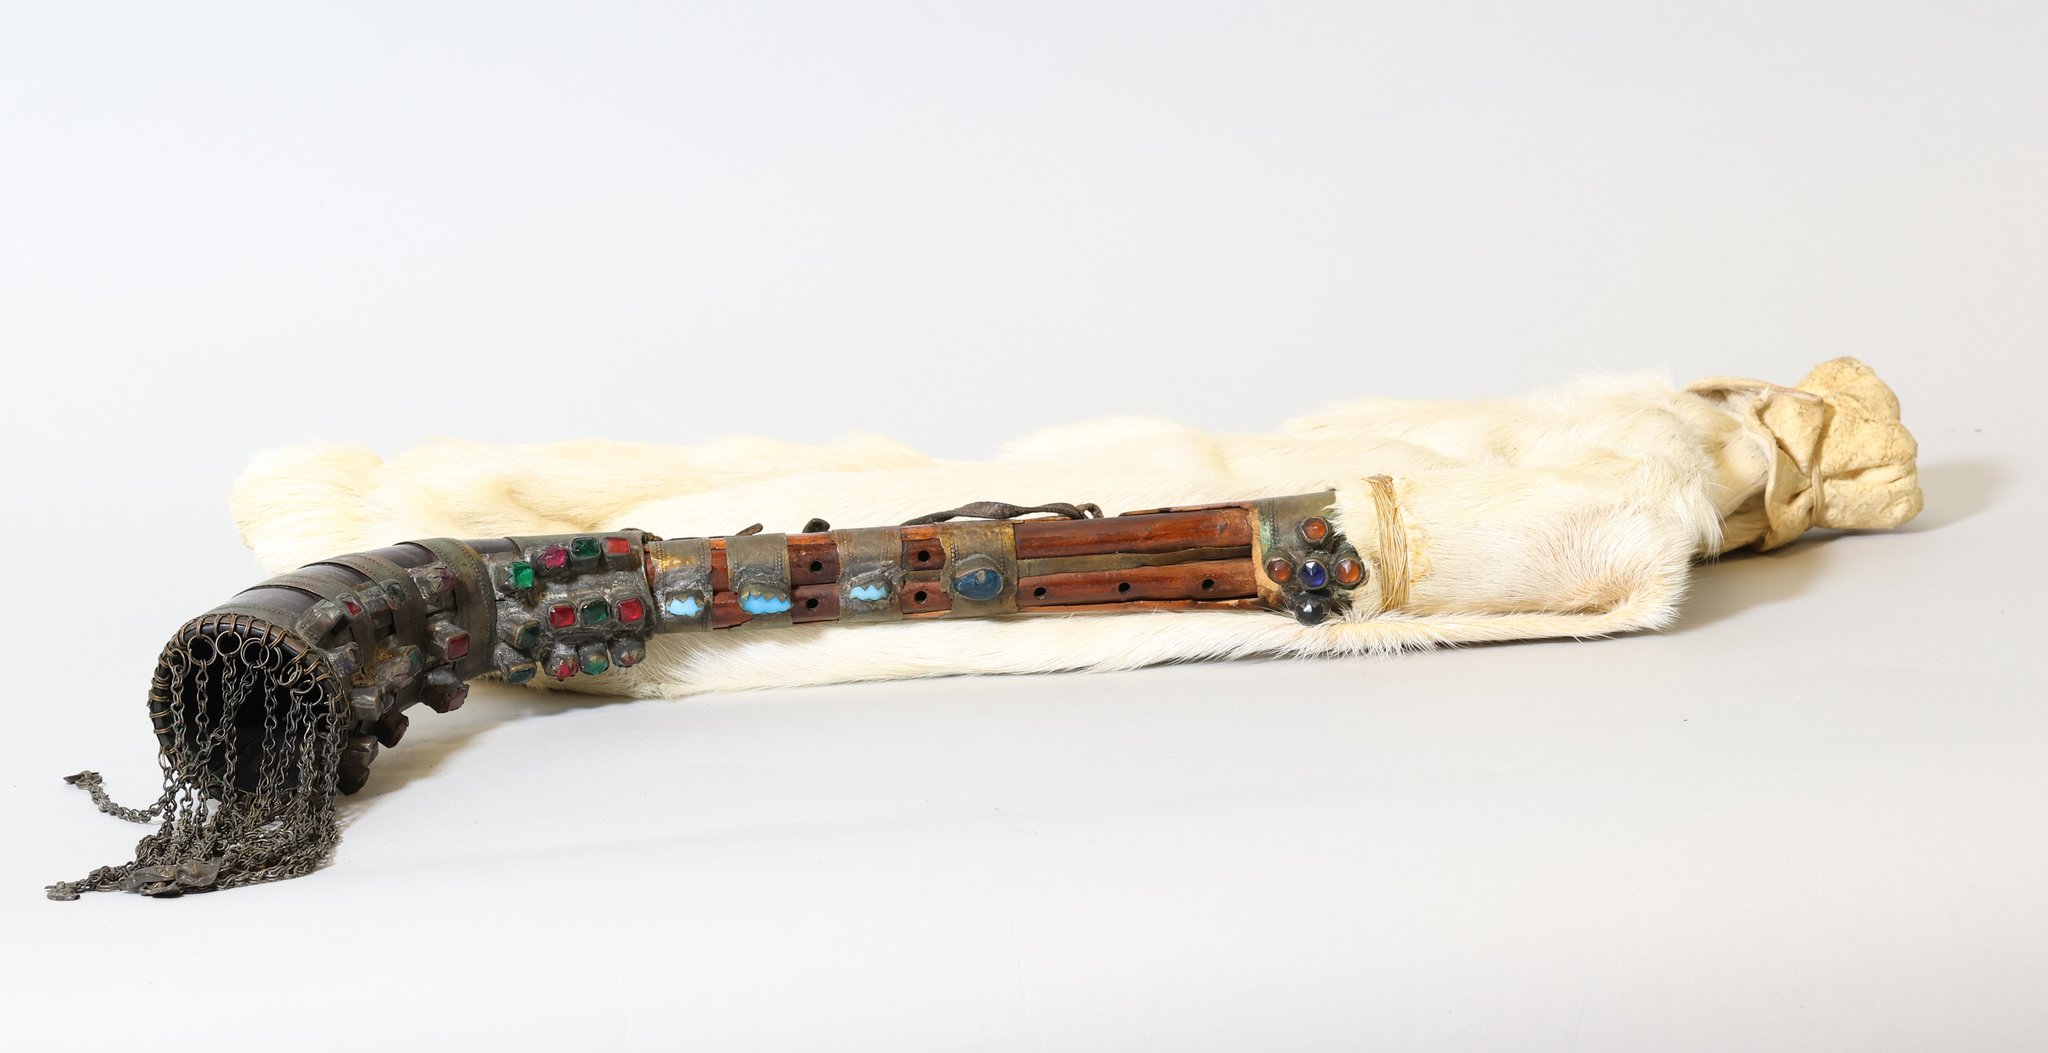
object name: gudastviri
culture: georgian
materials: brass, glass, horn, wood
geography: georgia